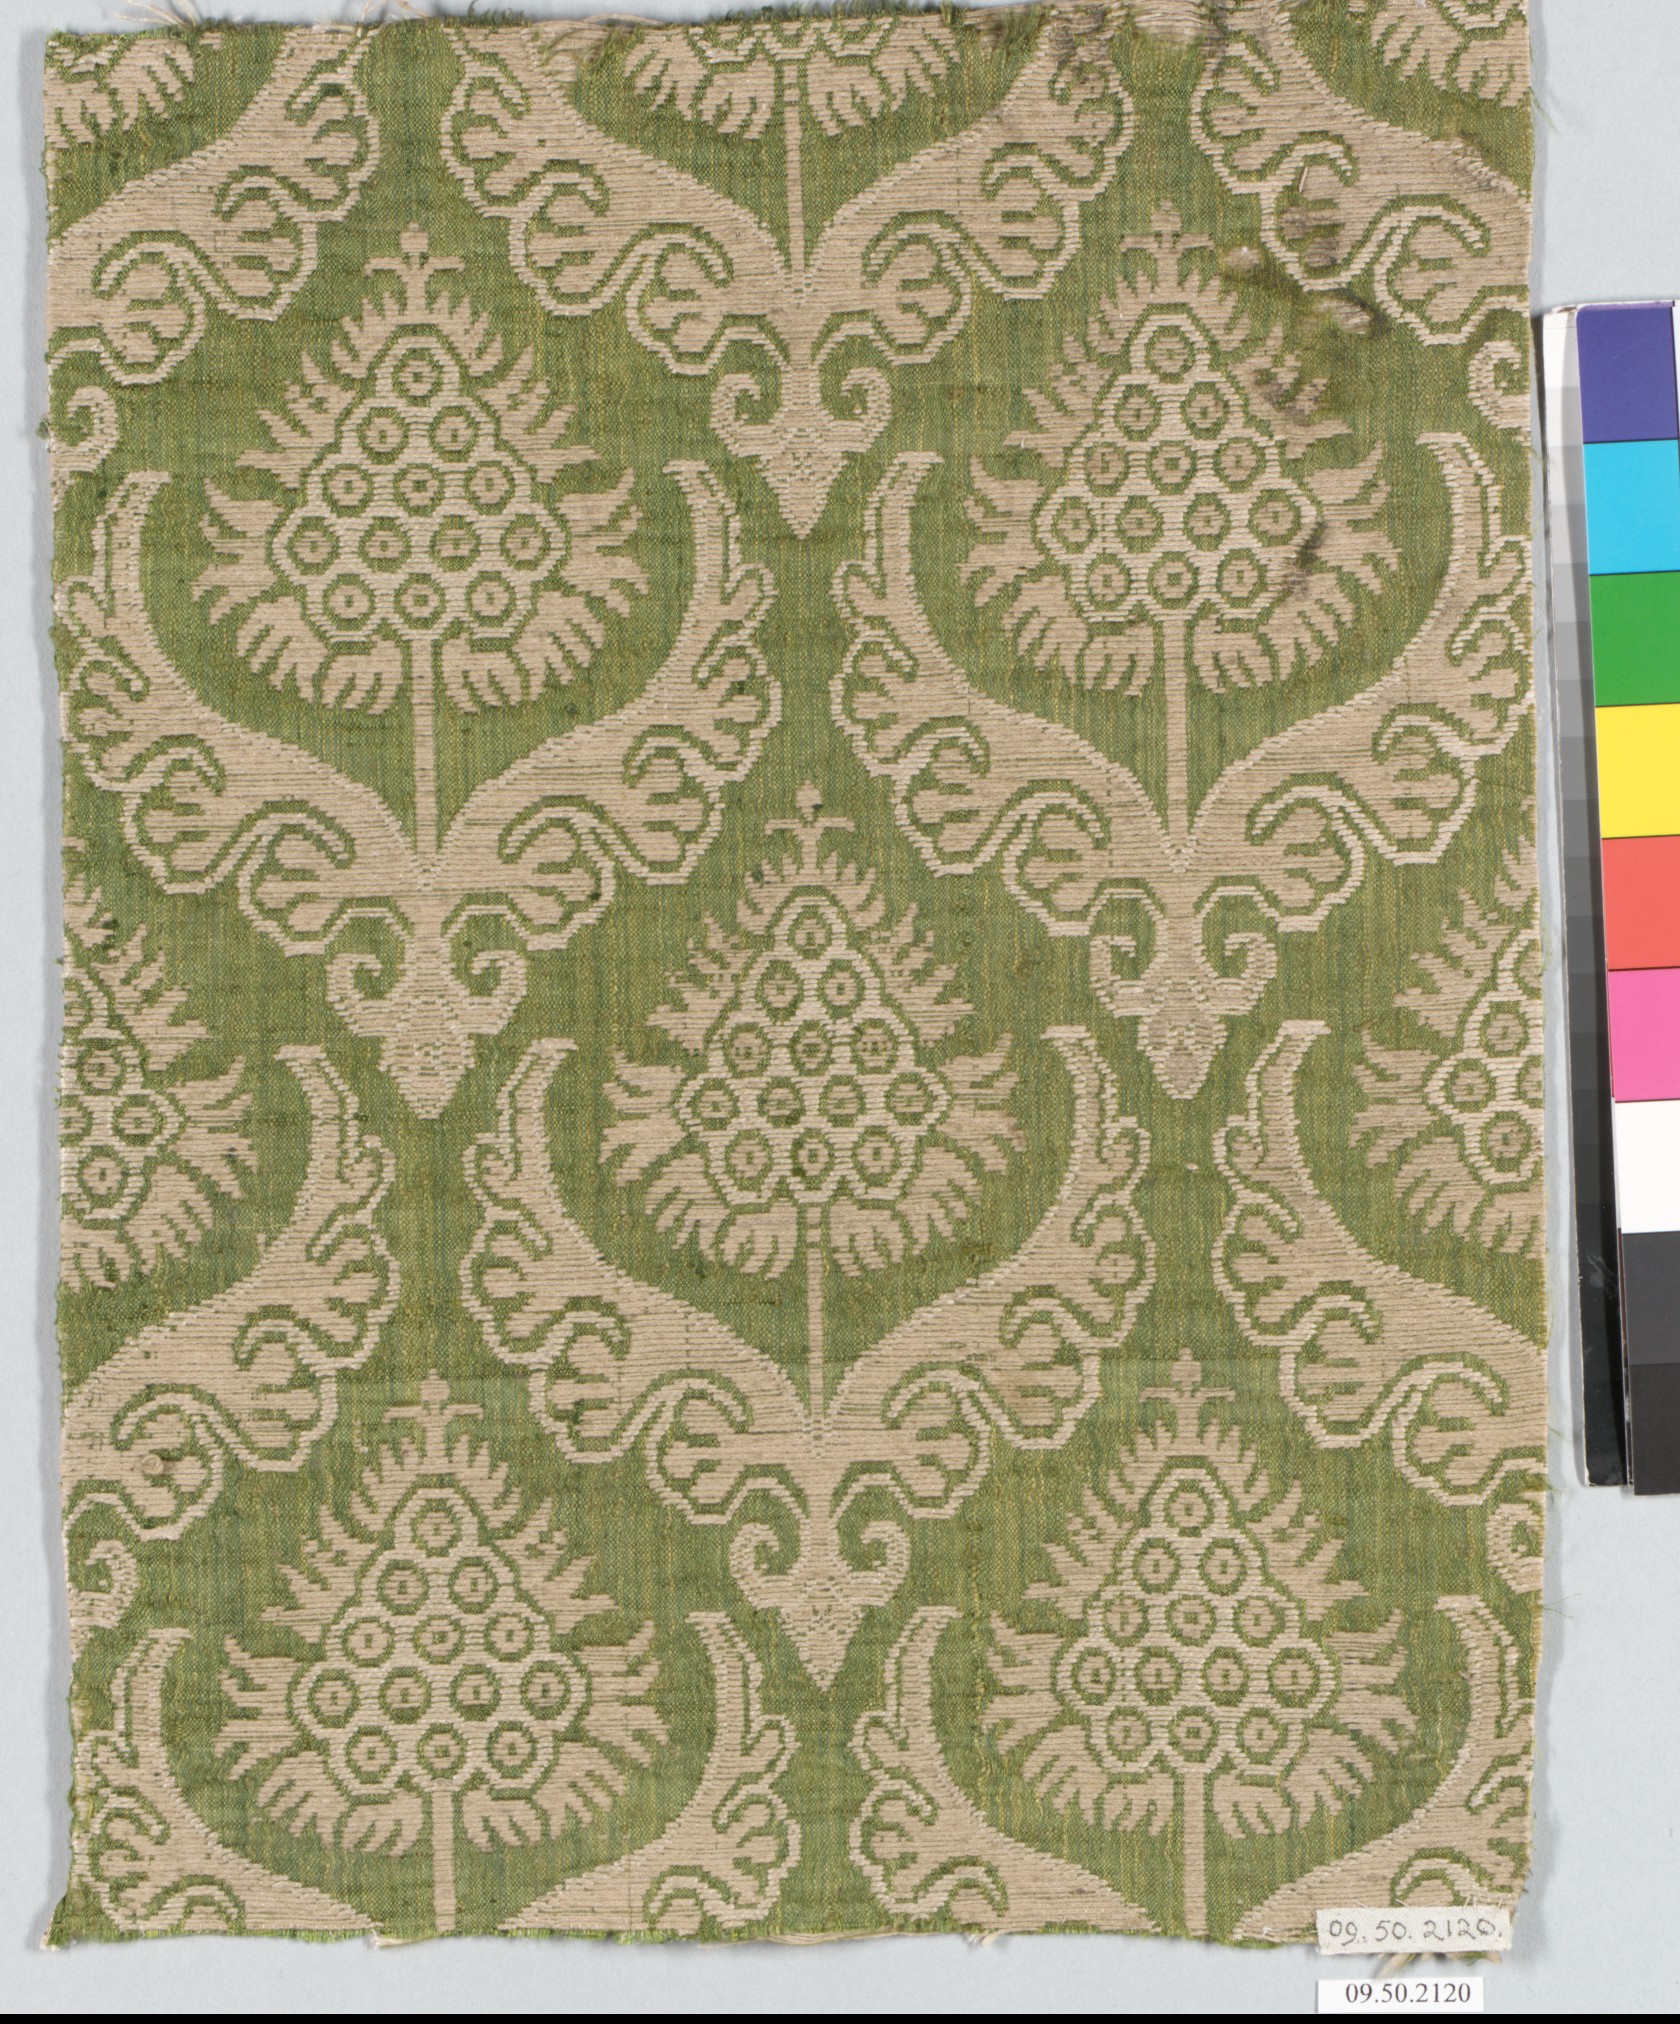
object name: fragment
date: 1801-1900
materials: cotton, silk